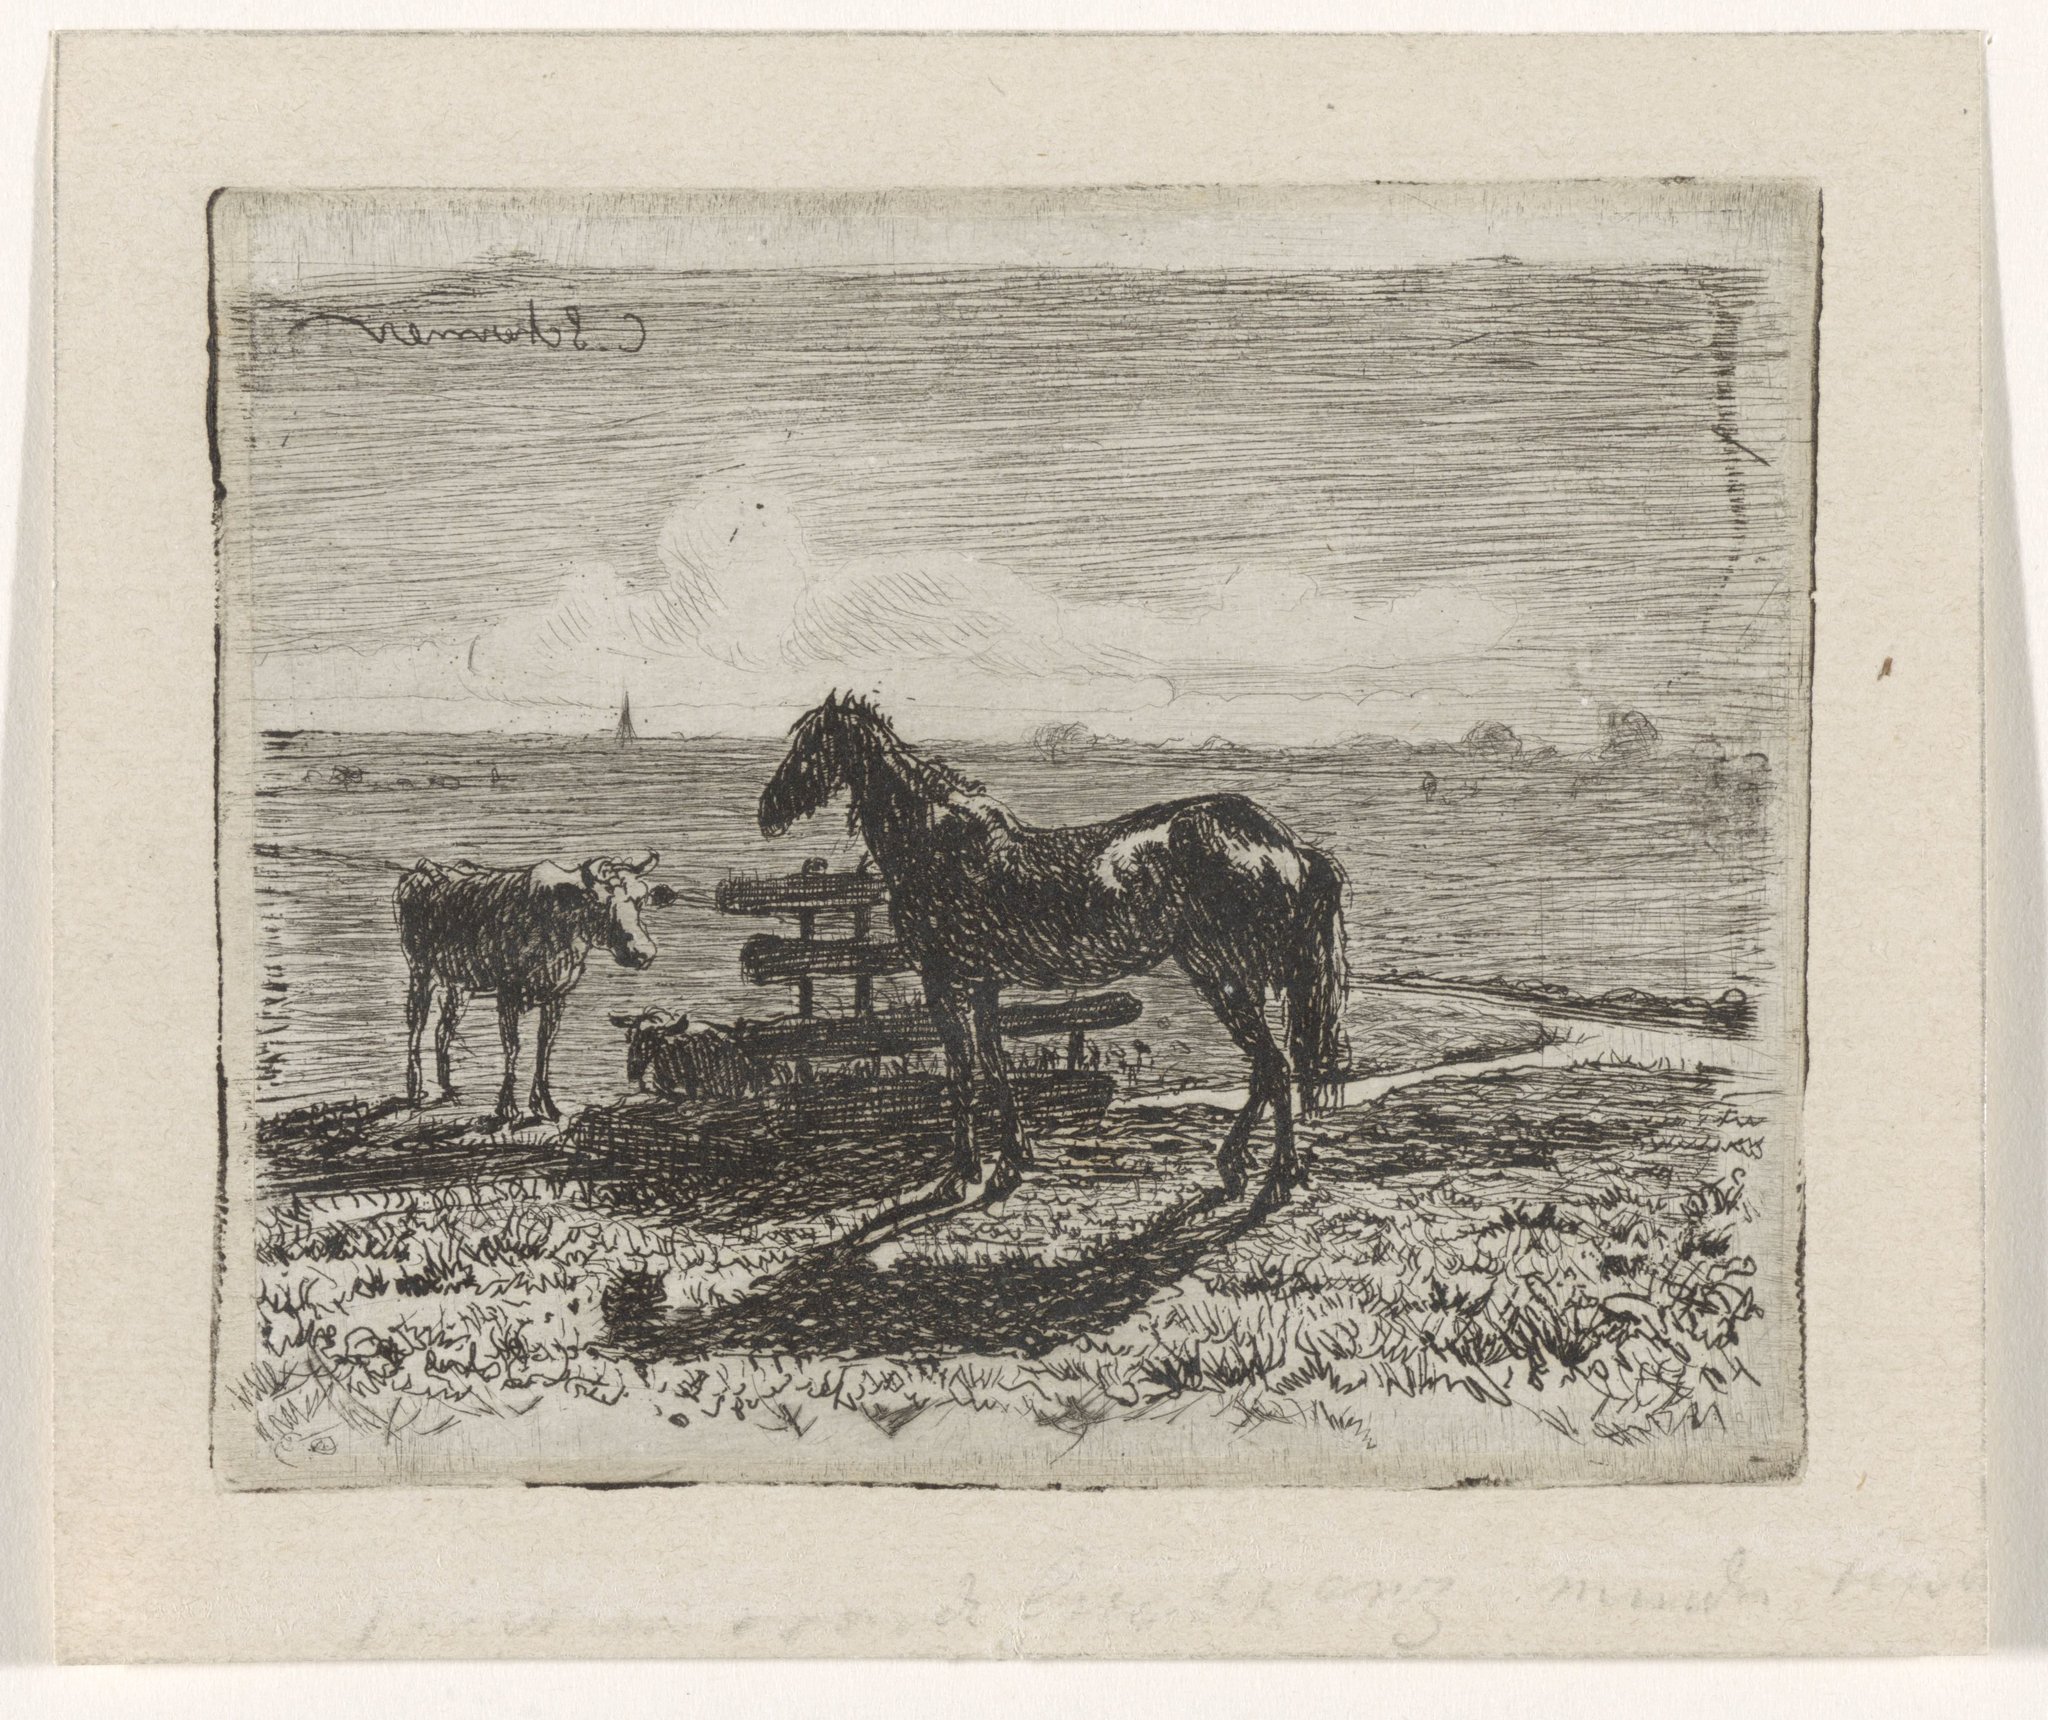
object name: print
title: Weiland met een paard en twee koeien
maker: cornelis albertus johannes schermer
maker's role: draughtsman, painter, print maker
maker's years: 1824-1915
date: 1834-1882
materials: paper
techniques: etching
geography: the hague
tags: cow, meadow, pasture, horse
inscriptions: collector's mark: Lugt 2228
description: Bij een hek in een weiland staan een paard en een koe. Achter het hek ligt een tweede koe.